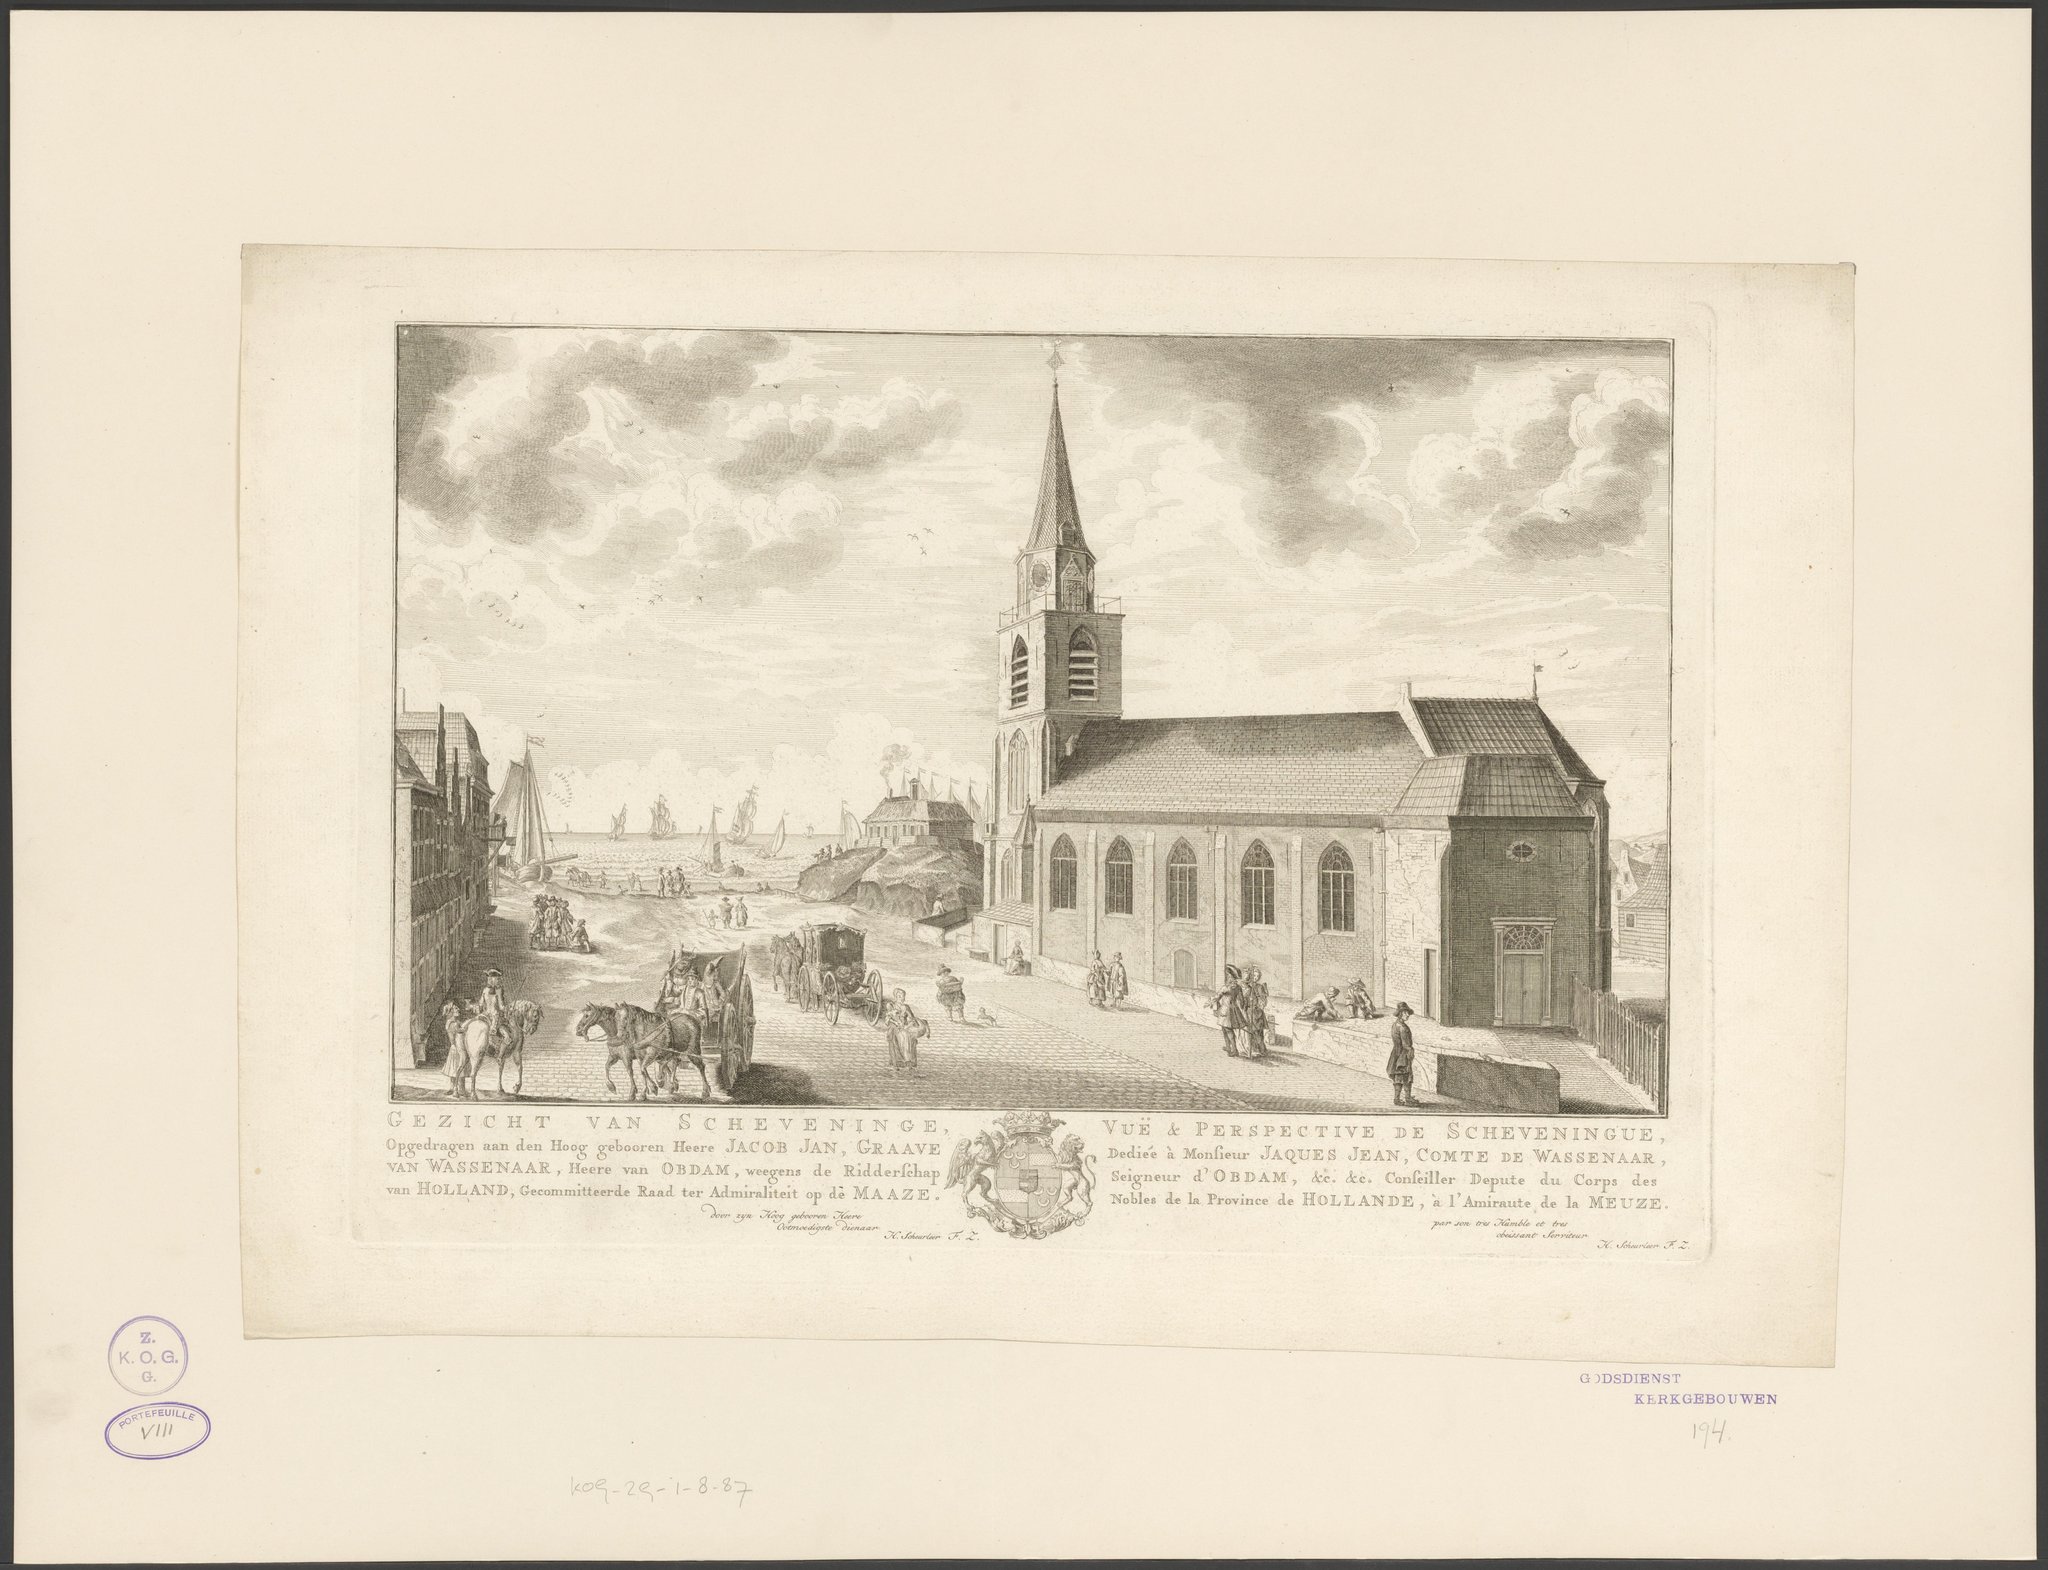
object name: print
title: Gezicht van Scheveninge / Vuë & perspective de Scheveningue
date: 1755-1762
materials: paper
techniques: engraving, etching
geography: the hague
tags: church (exterior), coast, village street (+ city(-scape) with figures, staffage)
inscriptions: collector's mark, collector's mark: Lugt 1641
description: Gezicht op de Oude Kerk te Scheveningen, met op de achtergrond de Noordzee. Onder de voorstelling de titel en opdracht in het Nederlands en Frans, met in het midden het familiewapen van Jacob Jan van Wassenaer Obdam. Prent uit een serie van achttien gezichten in en om Den Haag. Onderwerpsrubrieken binnen de Atlas Zeden en Gewoonten: Kerk en kerkwezen & Armwezen en liefdadige instellingen; Kerkgebouwen elders. M-U.